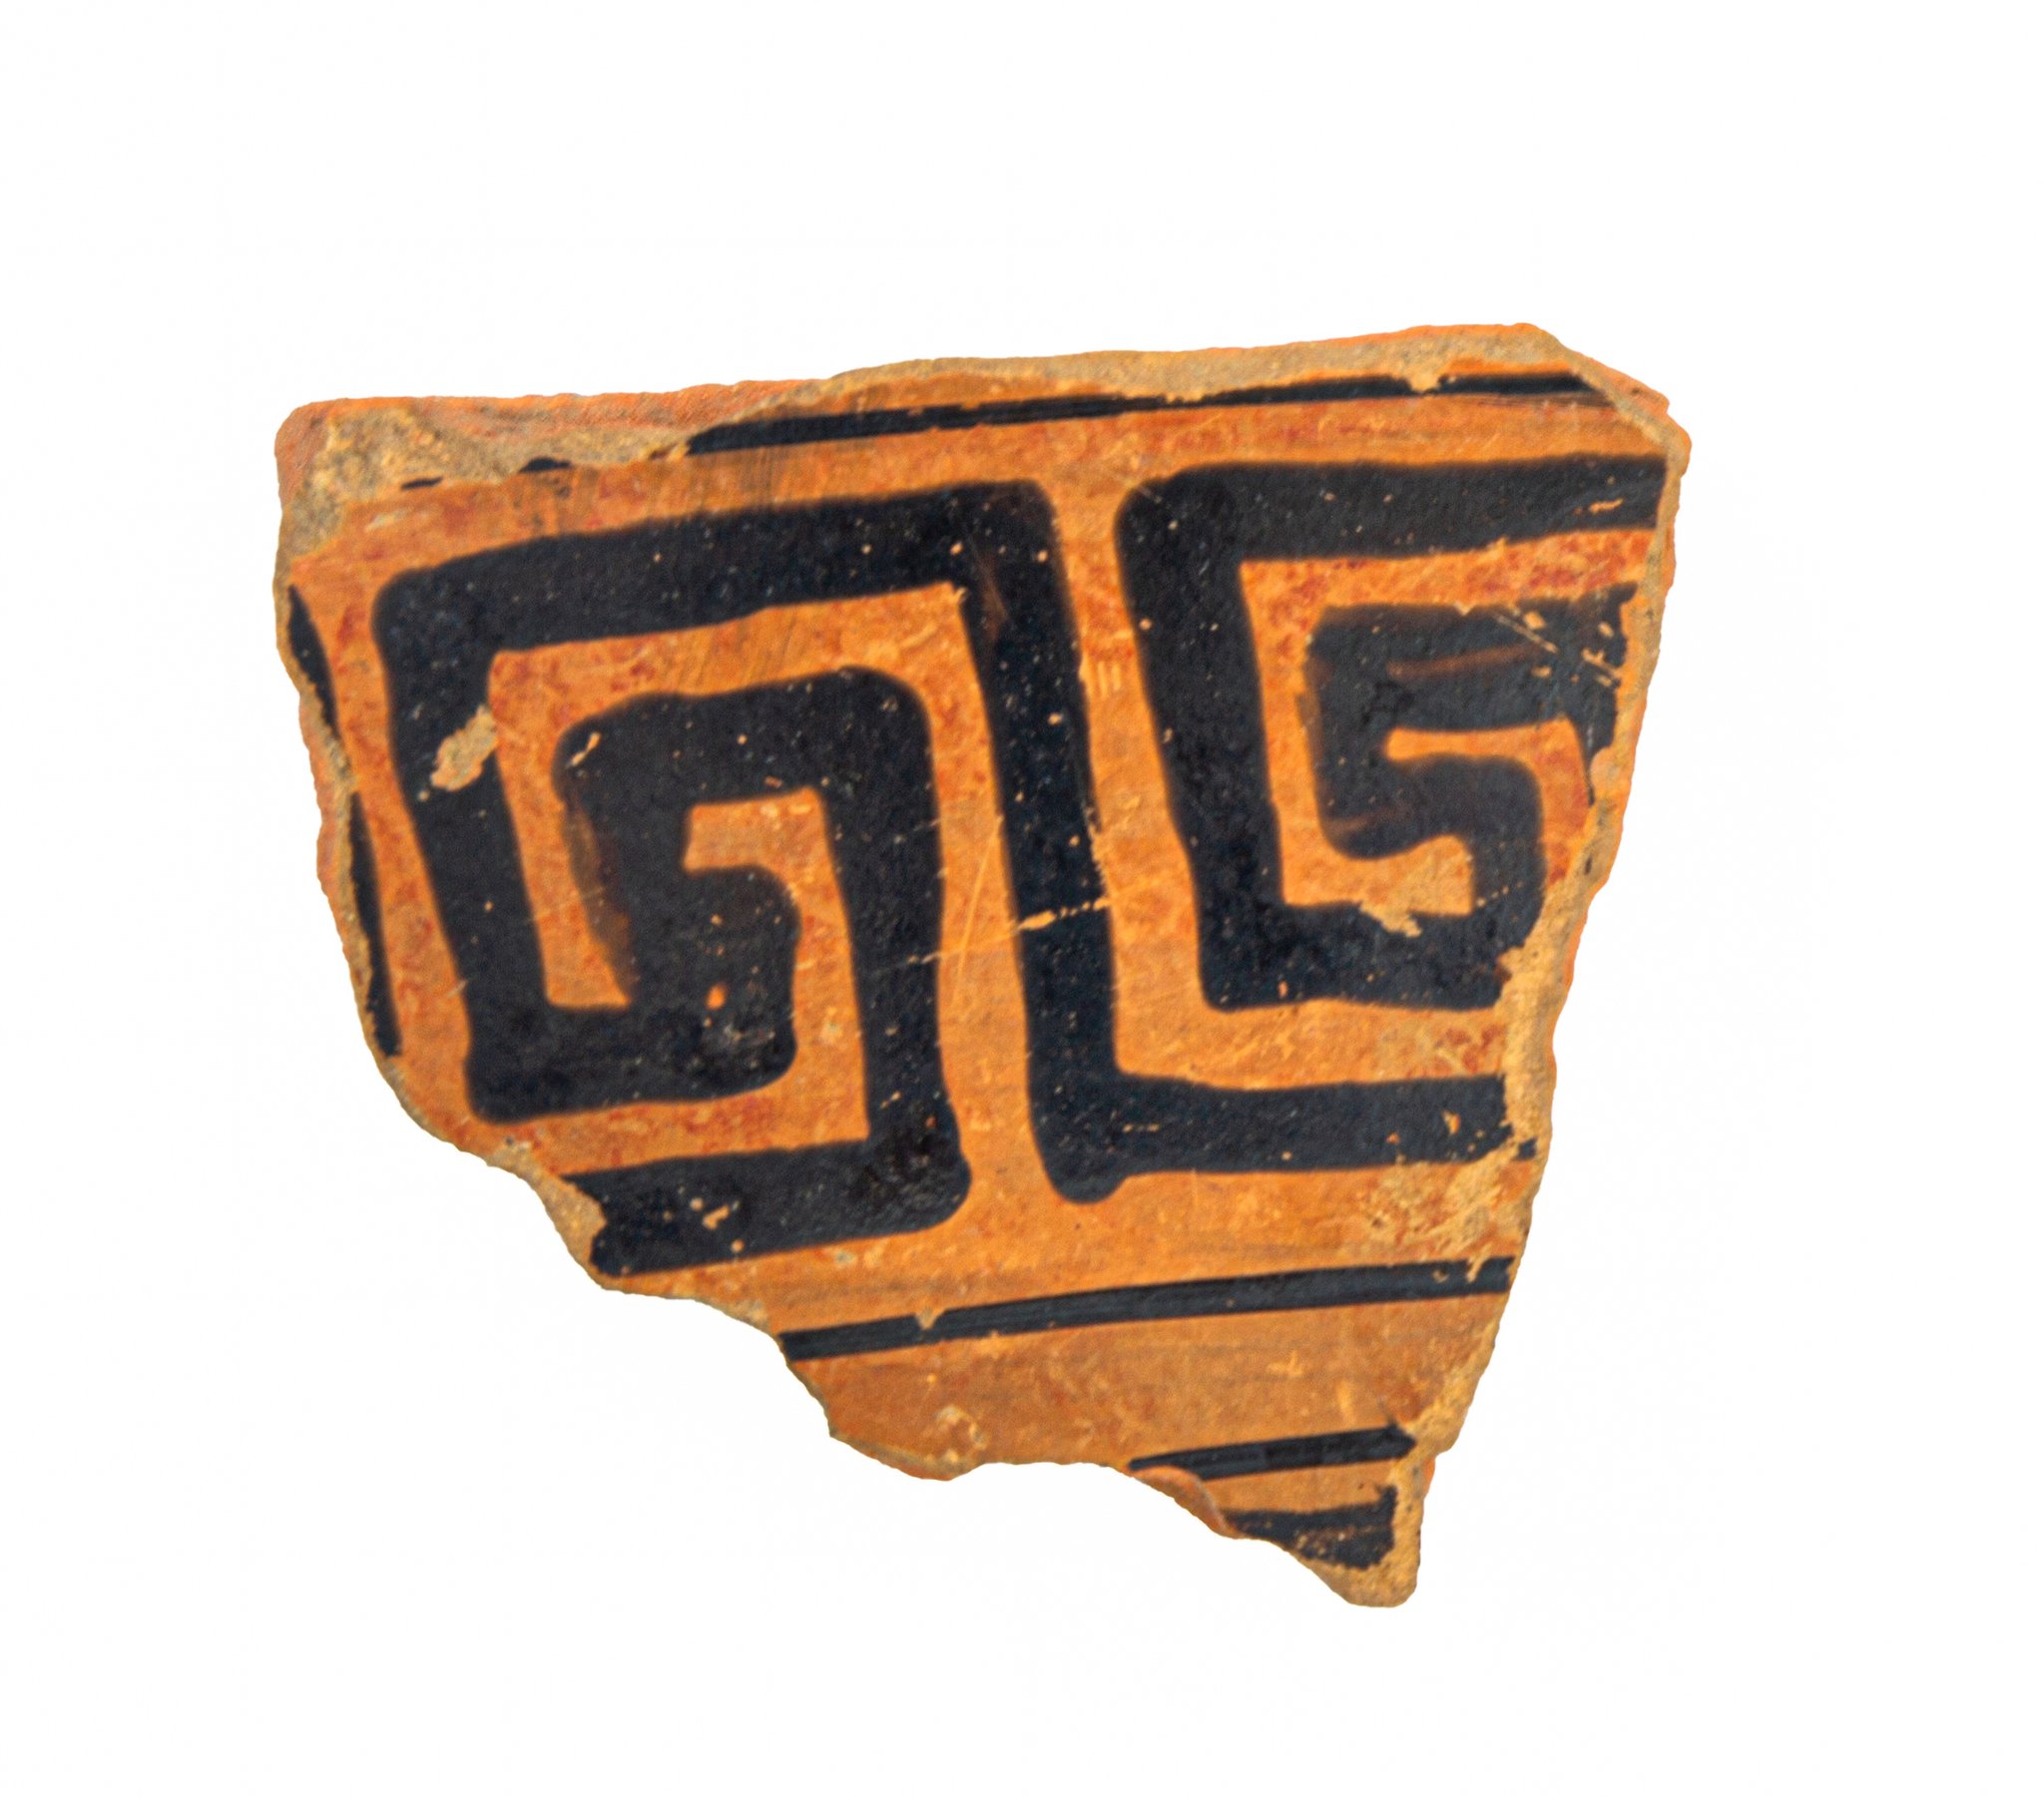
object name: volute krater fragment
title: Volute-krater fragment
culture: greek, south italian, apulian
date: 400-301 BCE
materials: terracotta